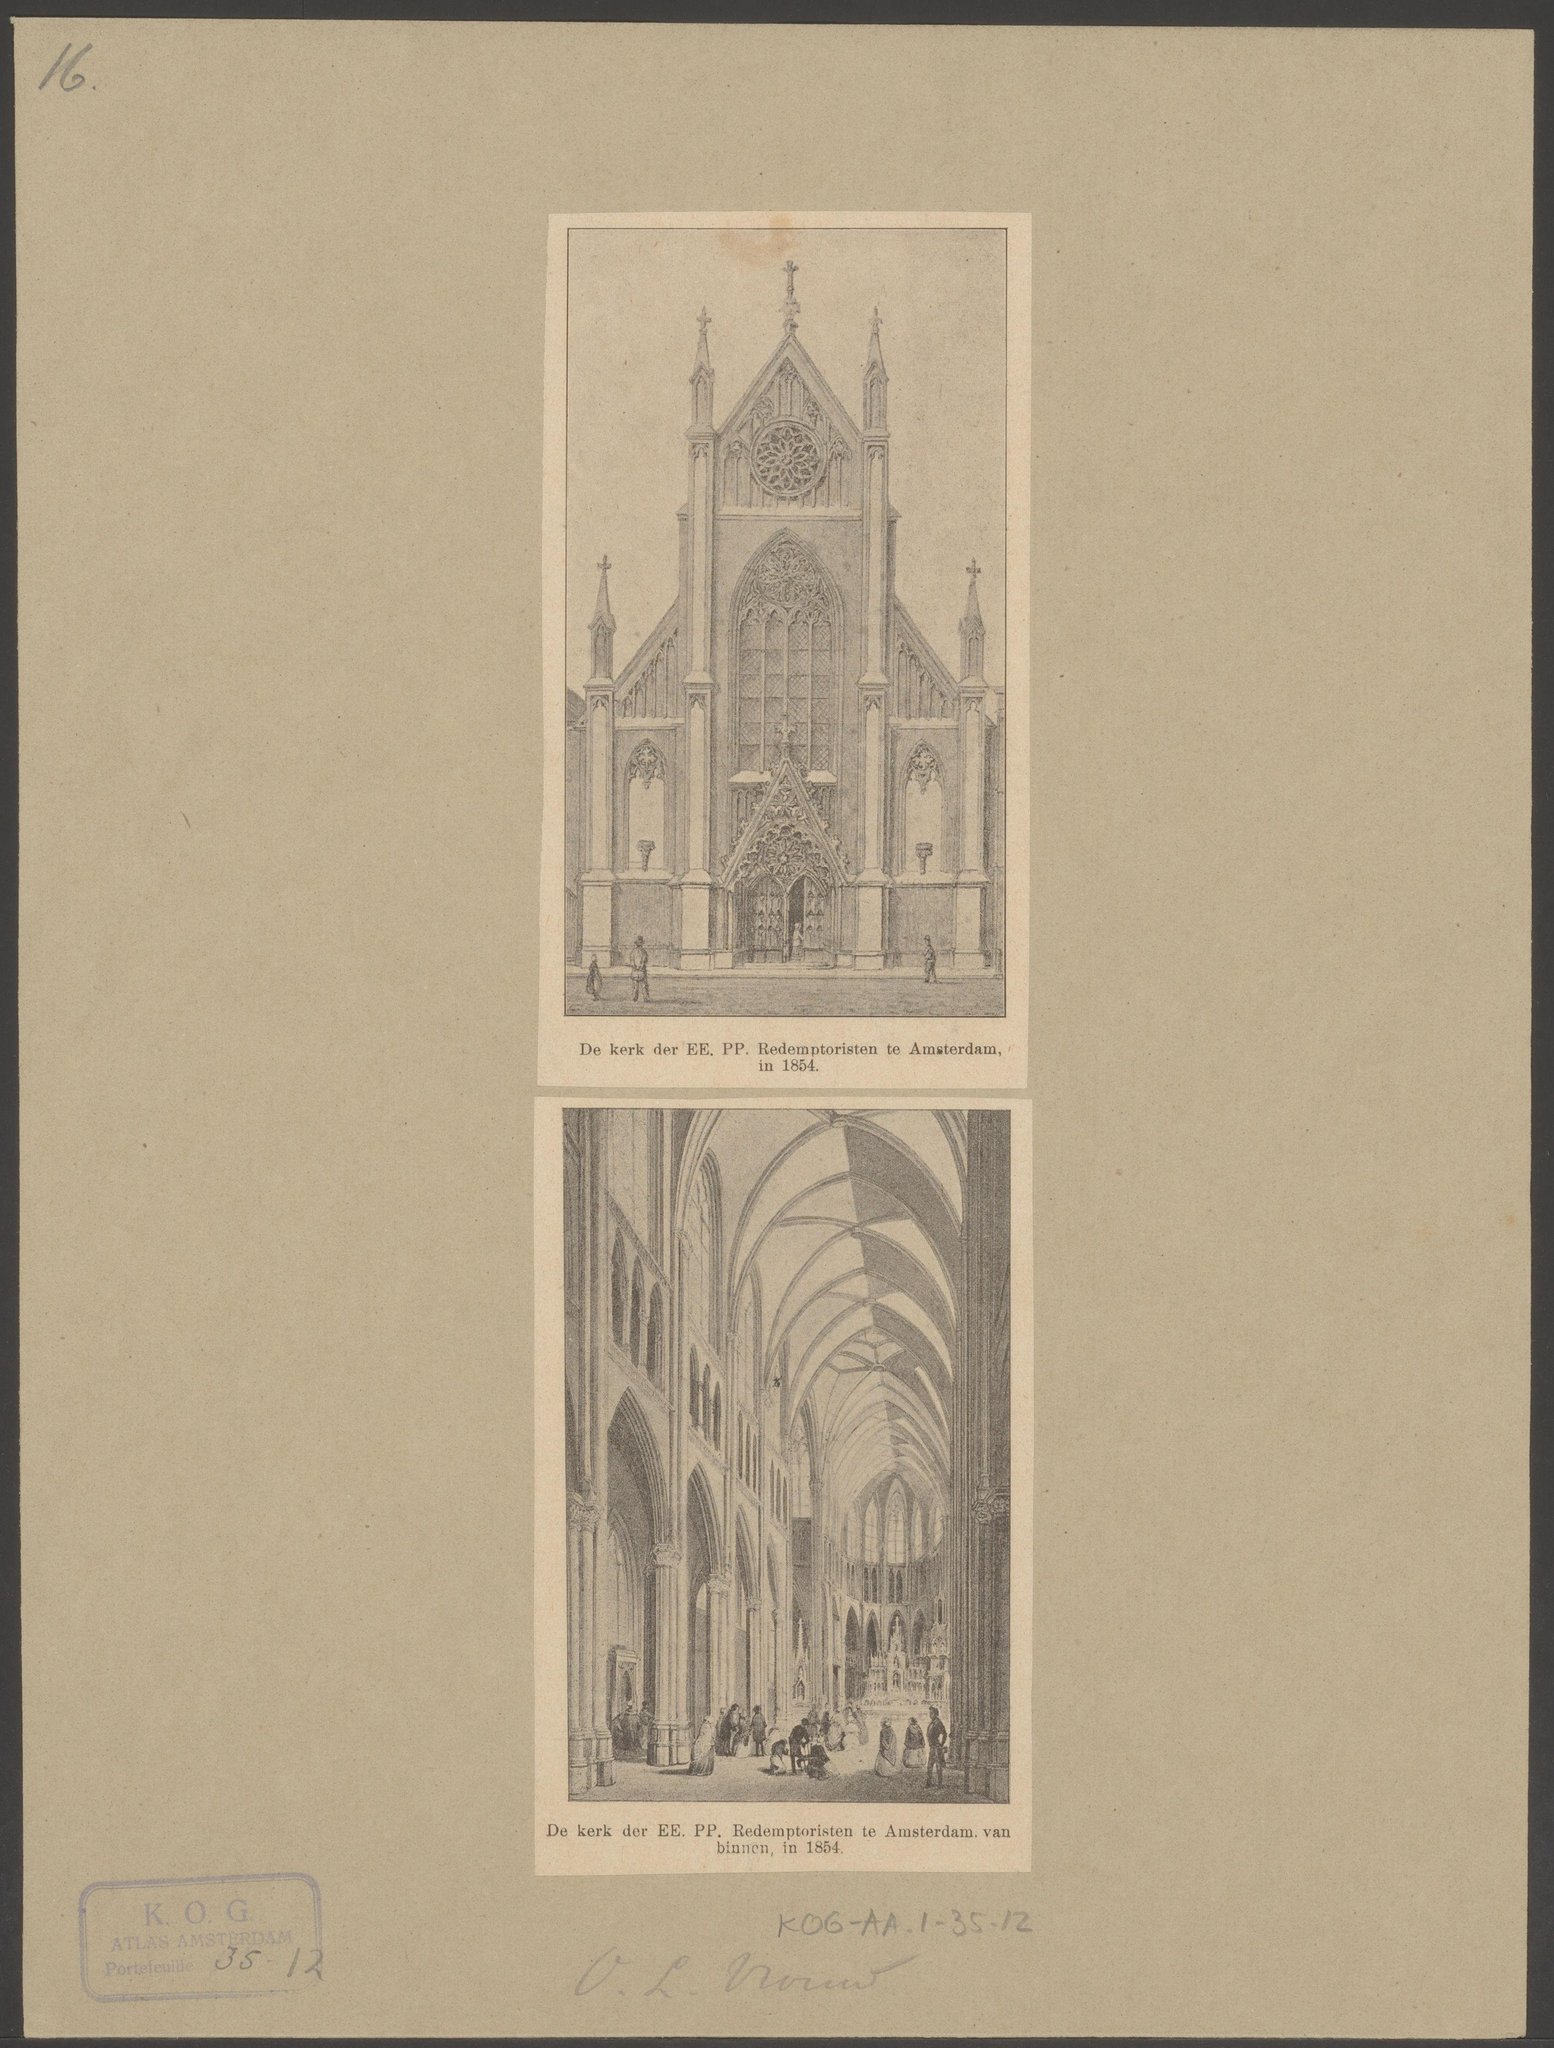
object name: photomechanical print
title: Gezichten op het exterieur en interieur van de Onze-Lieve-Vrouwekerk te Amsterdam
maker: Anonymous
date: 1900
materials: paper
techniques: letterpress printing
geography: amsterdam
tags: parts of church interior: aisle, roman catholic church, regular clerics, e.g. jesuits, redemptorists, parts of church exterior and annexes: façade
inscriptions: collector's mark: ‘ 35-12 ’ Lugt 1641b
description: Twee knipsels uit bladzijden 154-155 van het Geïllustreerd Zondagsblad voor Katholieken (1900), 11 november 1900. Onderwerpsrubriek binnen de Atlas Amsterdam: R.K. Gemeenten: Sint Nicolaaskerk t/m Willibrordus (Rustenburgerstraat).